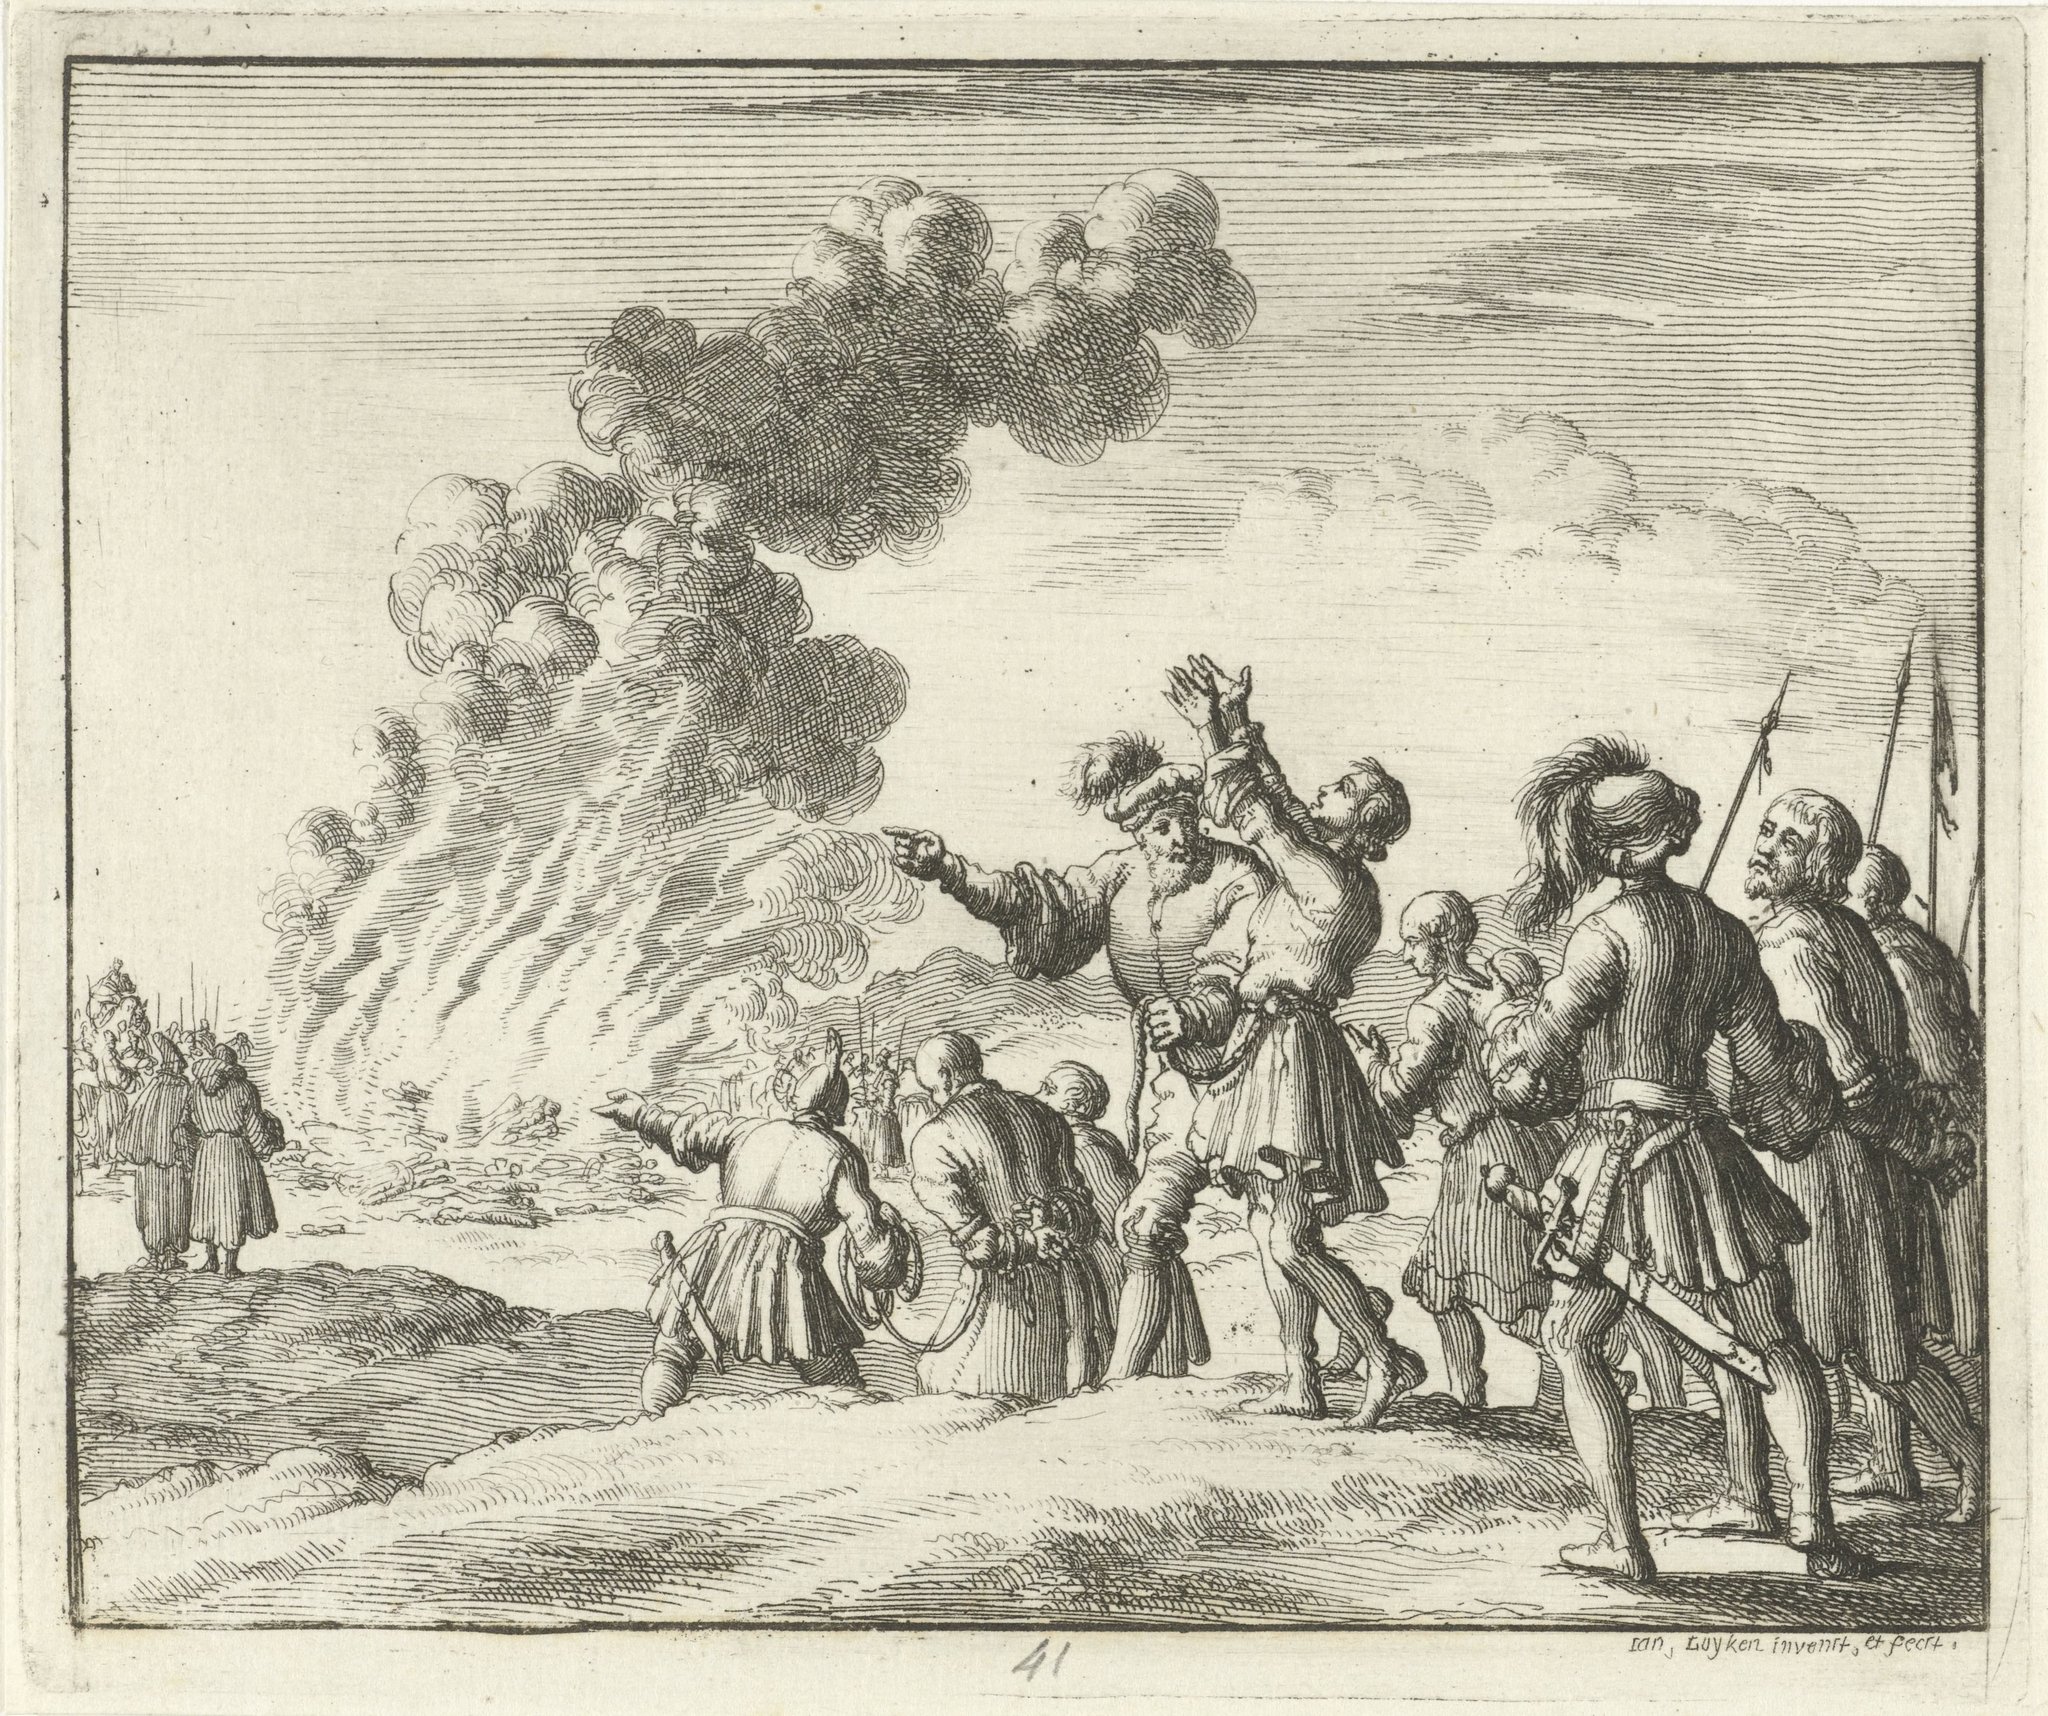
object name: print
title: Ketters uit Orléans naar de brandstapel gevoerd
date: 1685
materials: paper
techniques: etching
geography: amsterdam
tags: execution of heretic, e.g. by burning at the stake, 'auto-da-fé', (person under sentence of death) on the way to the scaffold or place of execution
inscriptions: collector's mark: Lugt 2228, number: ‘41’